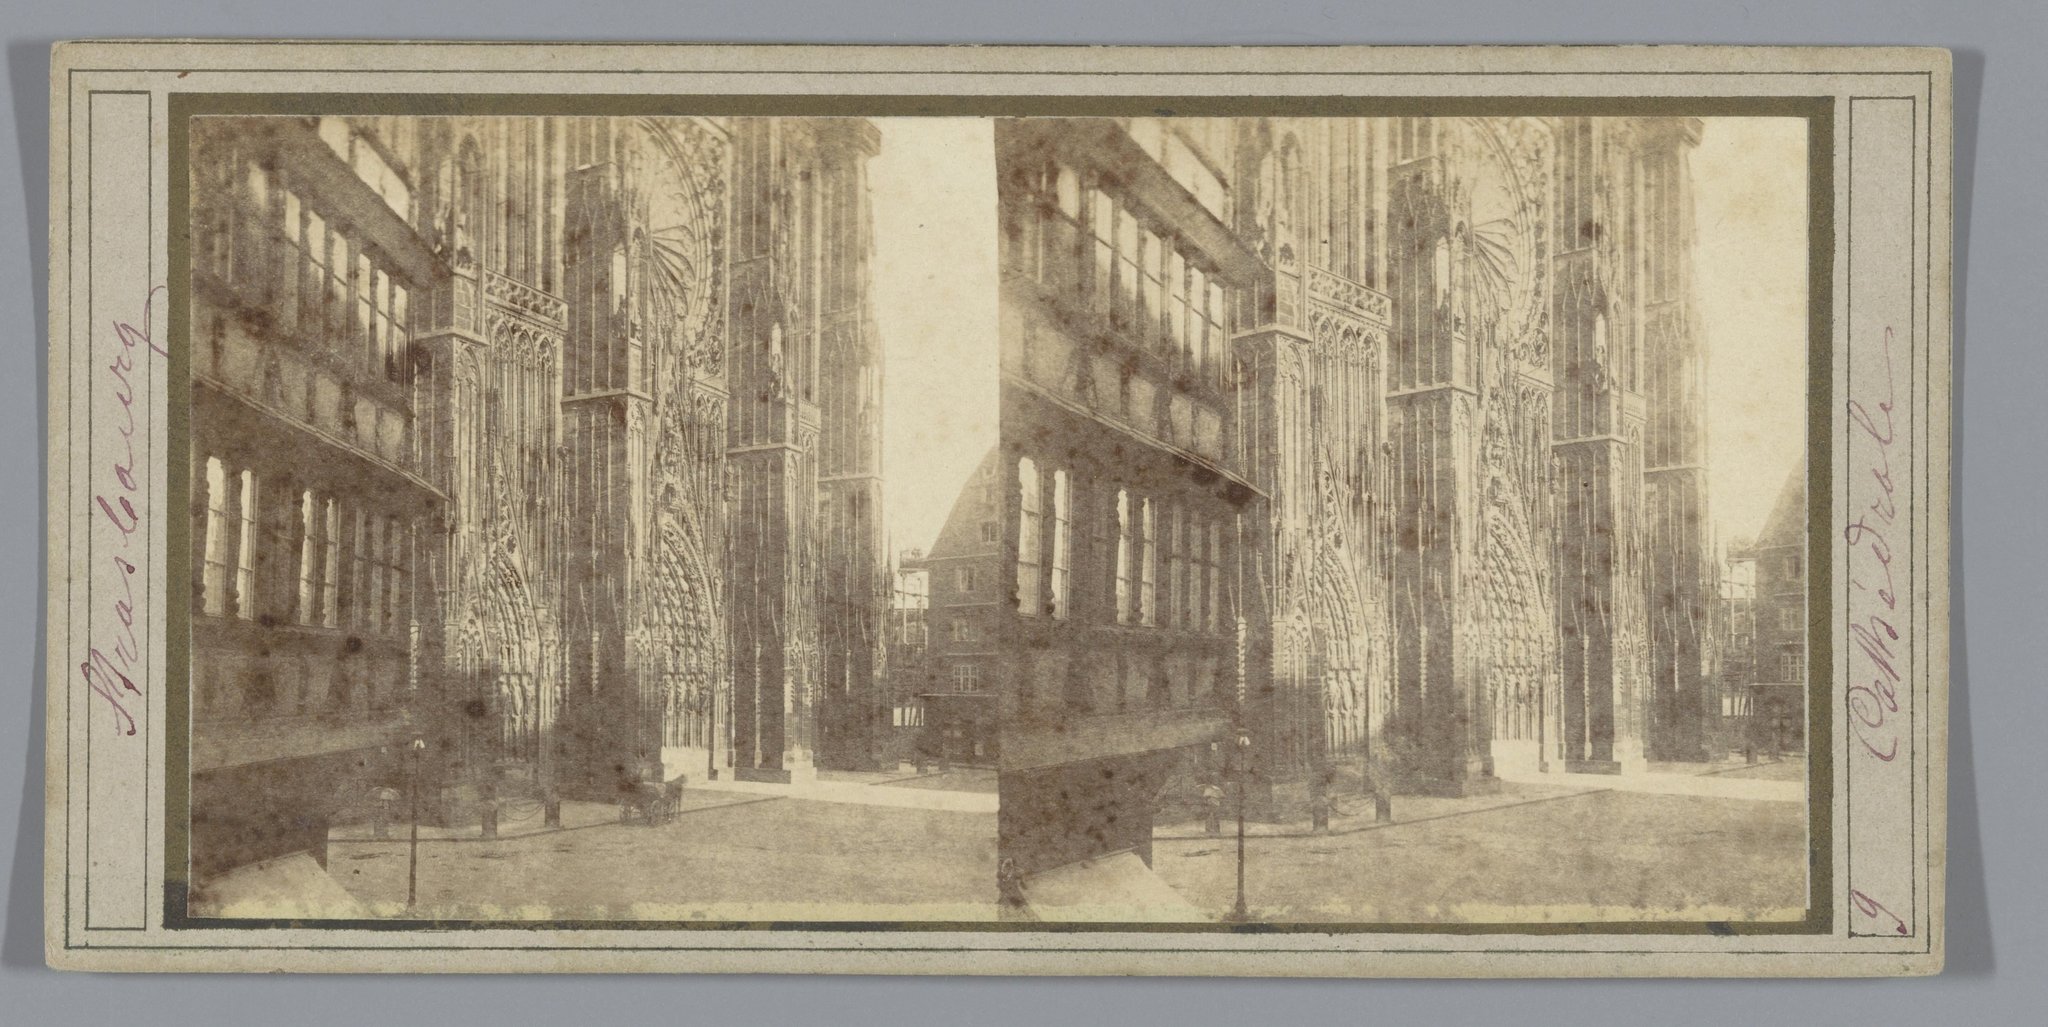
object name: stereograph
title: Strasbourg, Cathedrale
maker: Anonymous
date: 1850-1880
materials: cardboard, photographic support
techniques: albumen print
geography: straatsburg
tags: parts of church exterior and annexes: portal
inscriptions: number: ‘9’